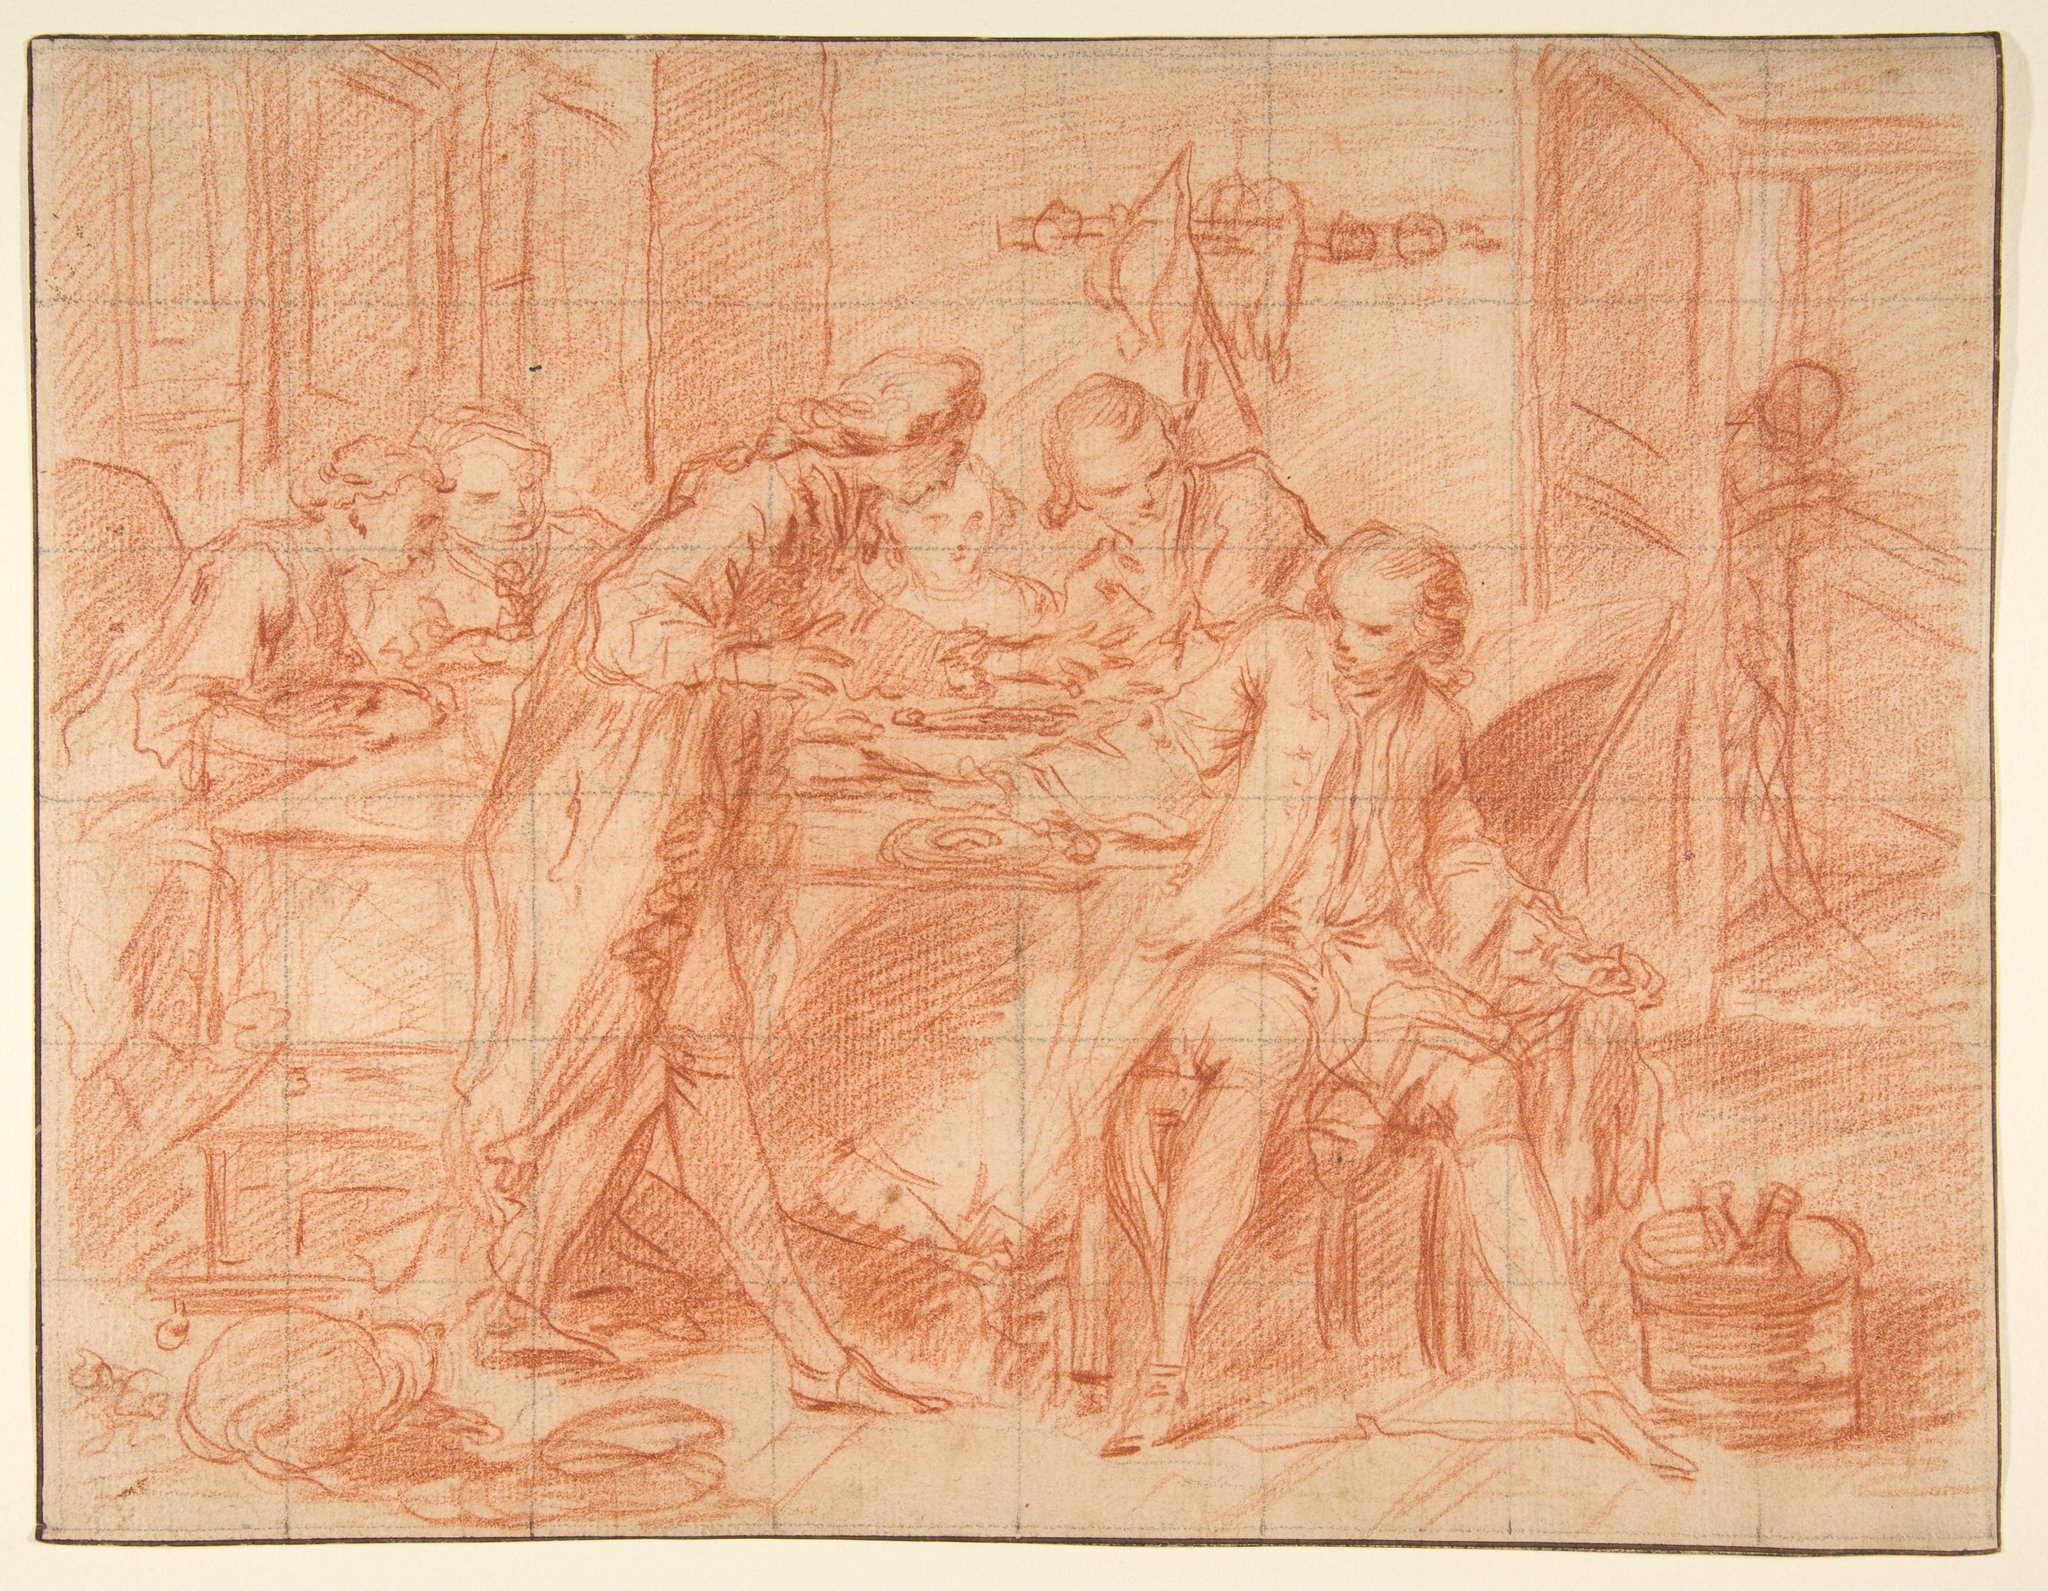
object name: drawing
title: Paté d'Anguille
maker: nicolas lancret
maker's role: artist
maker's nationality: french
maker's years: 1690-1743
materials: chalk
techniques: drawing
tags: men,women,tables